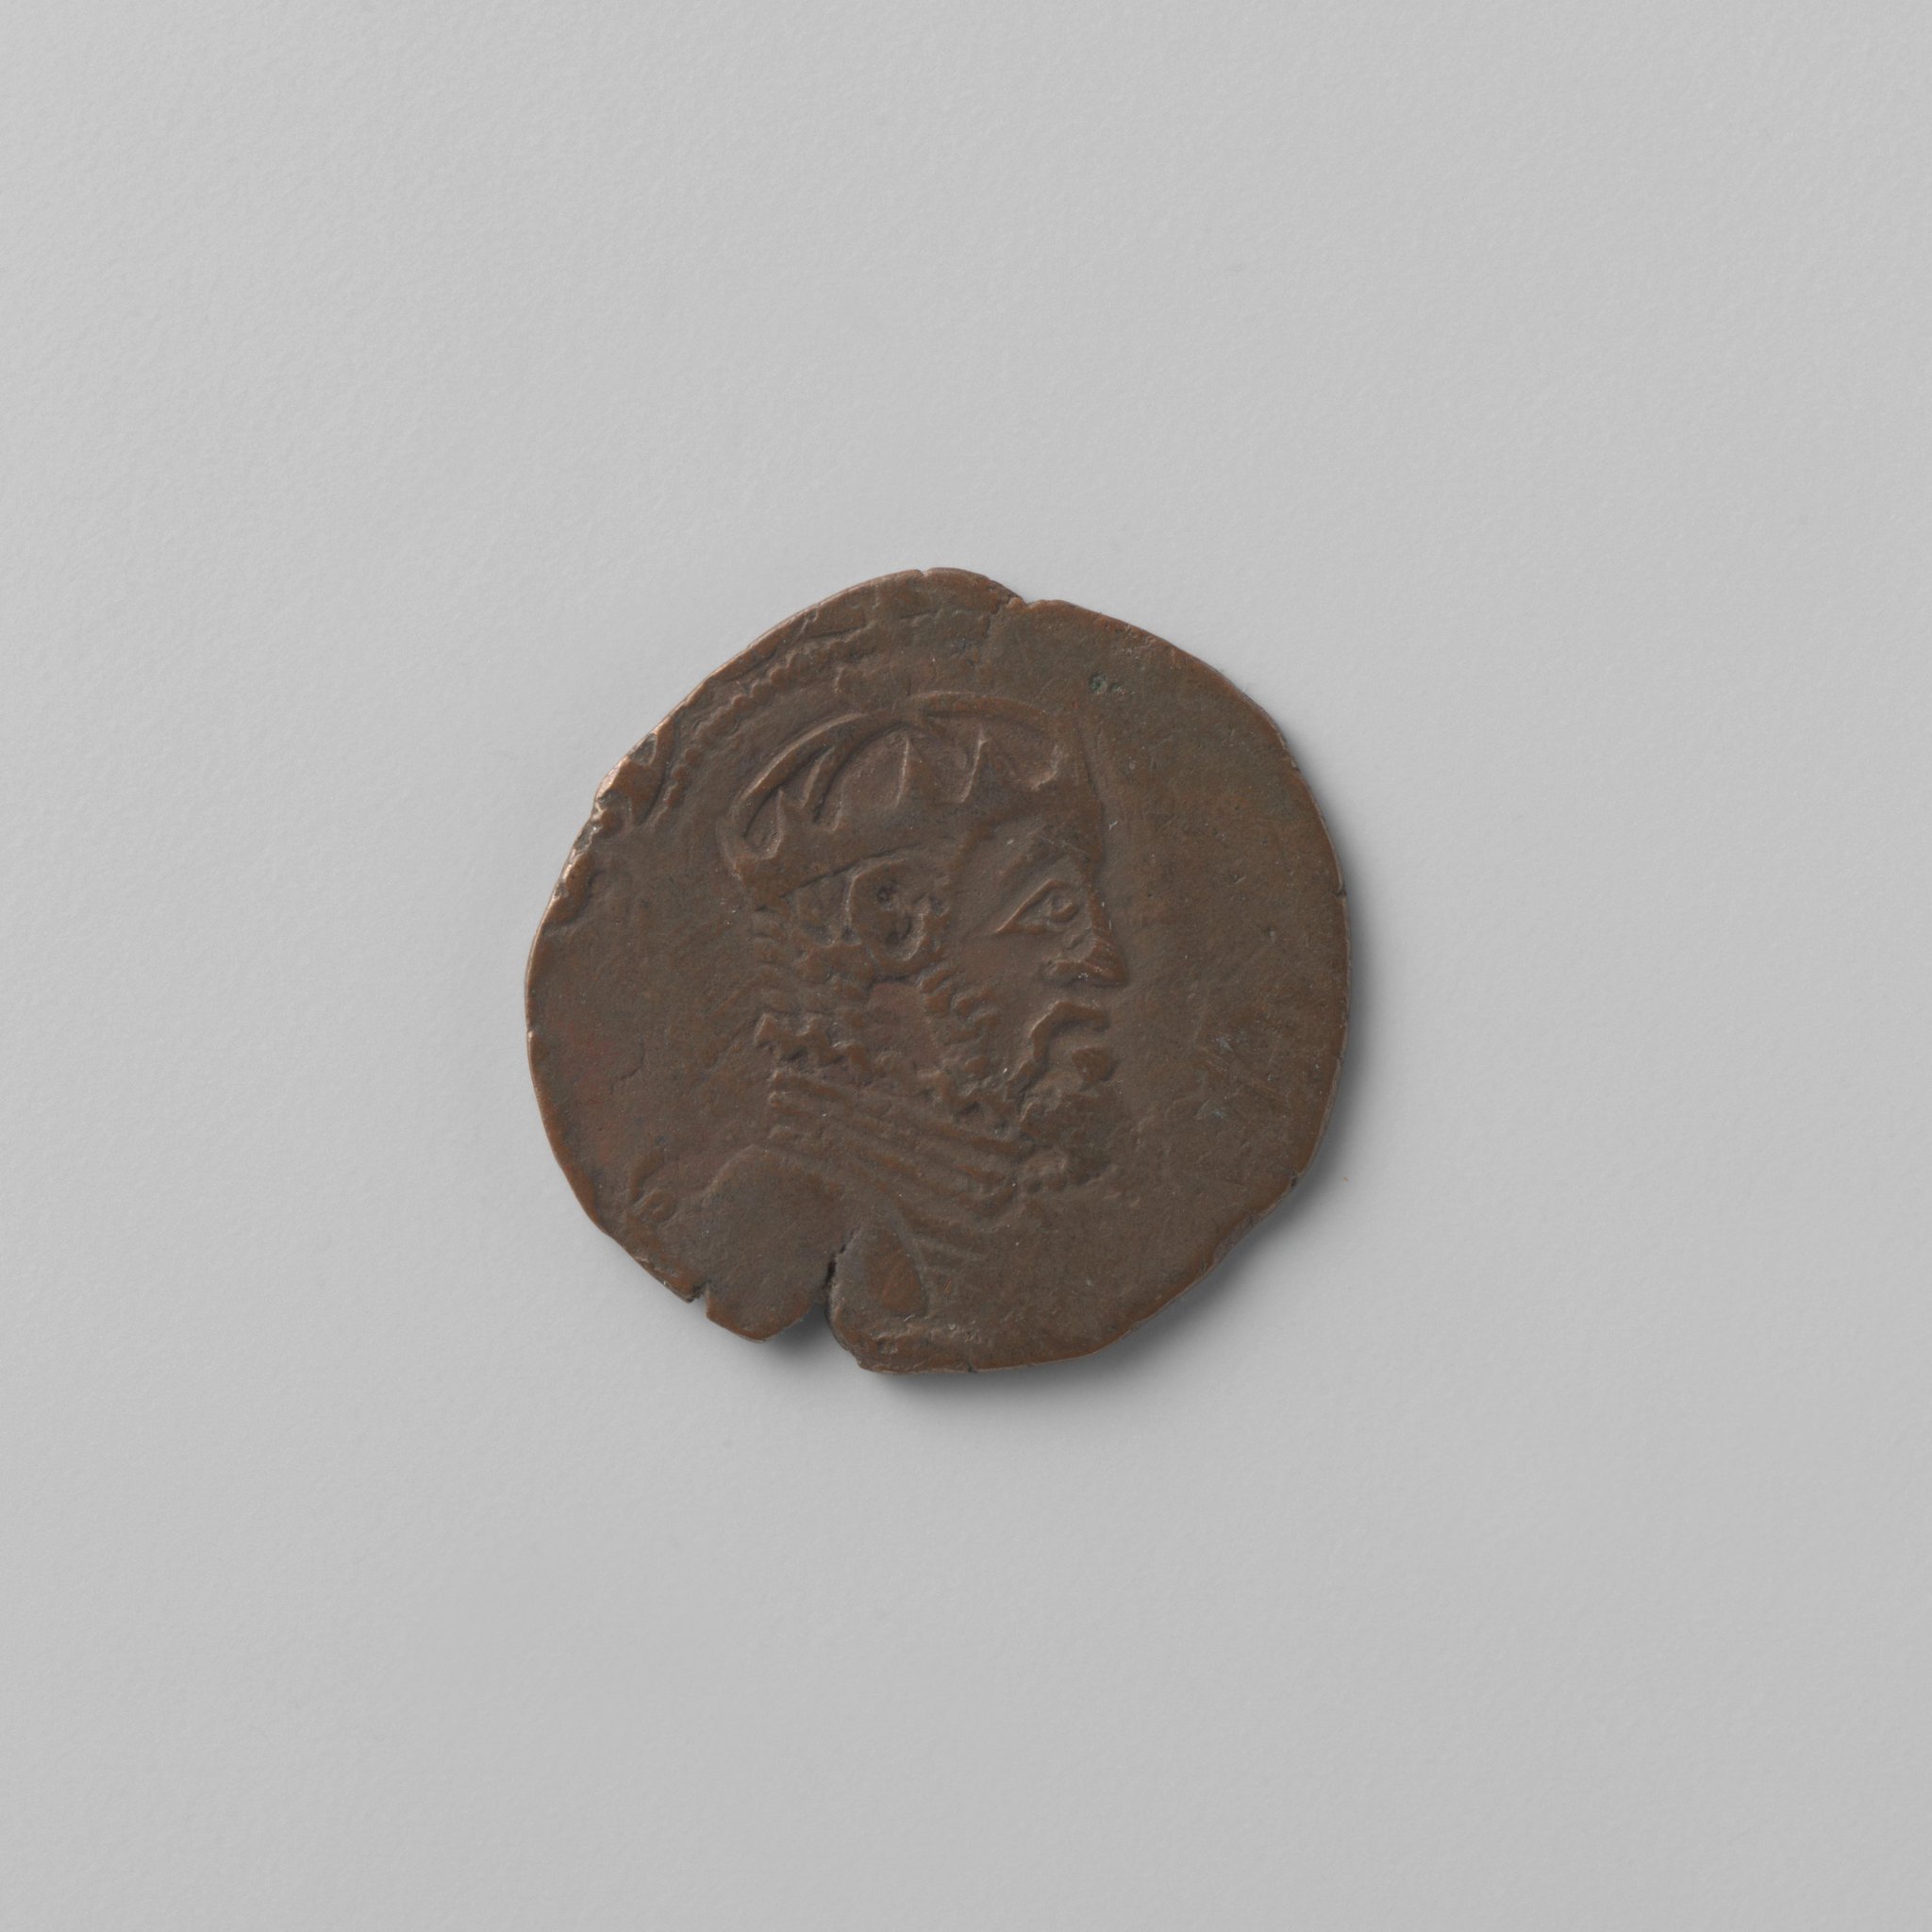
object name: coin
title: Gelderland, Philips II, korte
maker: philip ii of spain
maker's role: koning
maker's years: 1527-1598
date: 1558-1565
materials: copper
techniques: striking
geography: gelderland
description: Koperen munt. Voorzijde: portret Philips II naar rechts. Keerzijde: vier vuurstenen met vonken in kruisvorm.